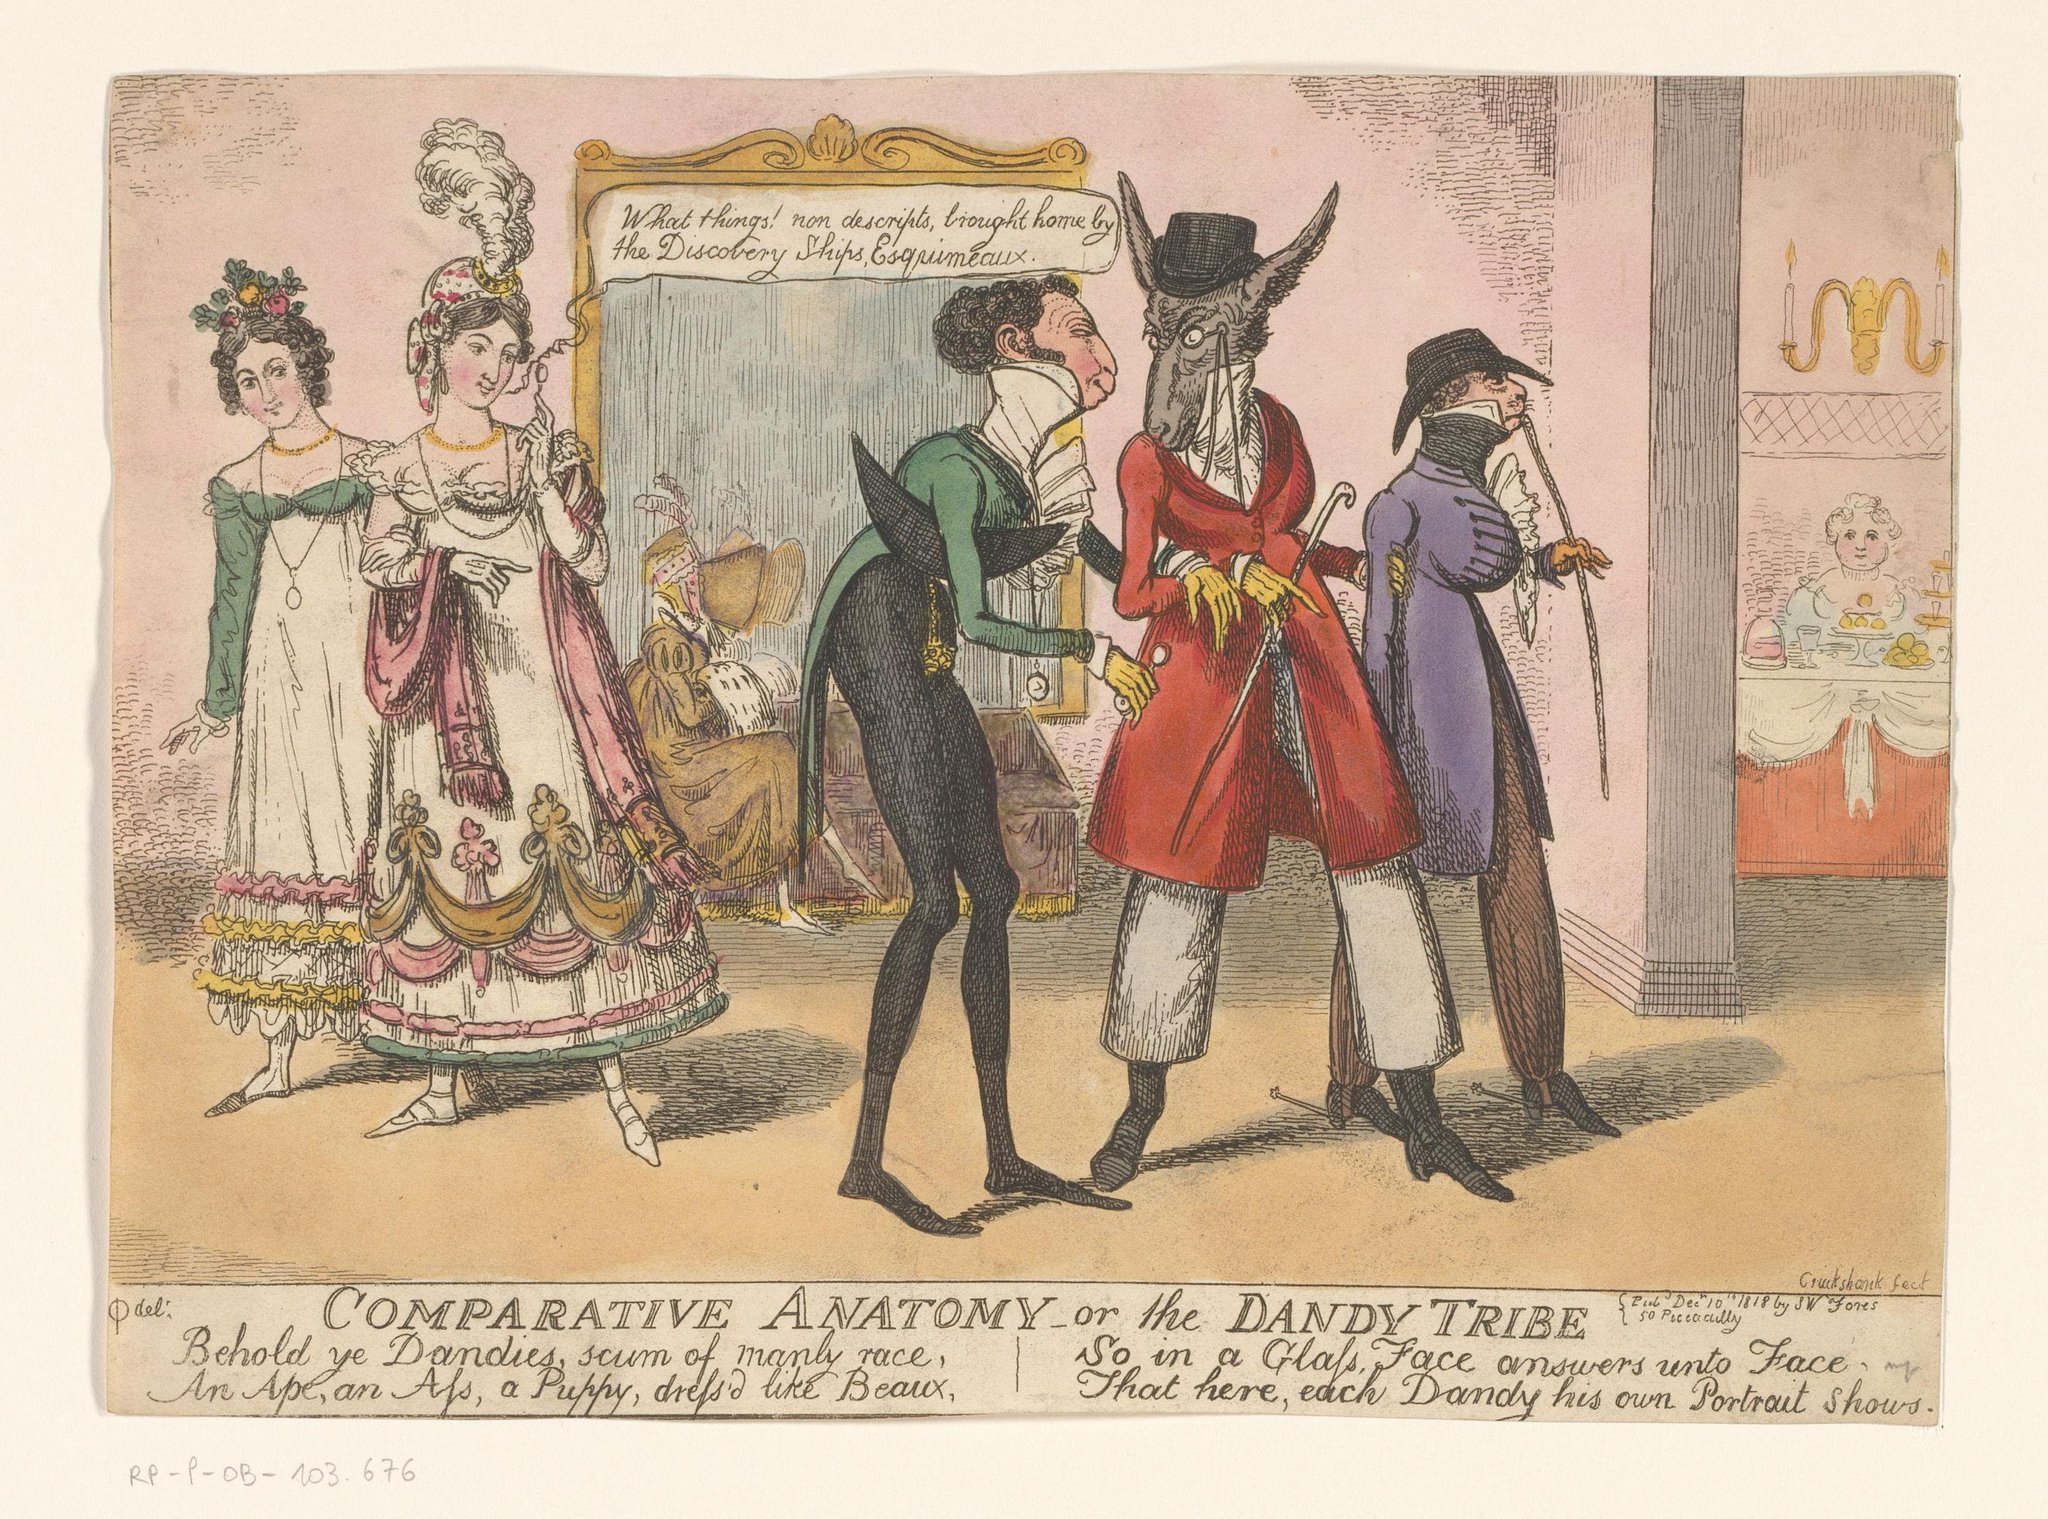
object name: cartoon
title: Comparative Anatomy - or the Dandy Tribe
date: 1818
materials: paper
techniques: etching, hand coloring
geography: london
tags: dandy, beau, political caricatures and satires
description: Spotprent met drie dandy's in de Assembly rooms te Bath. De middelste heeft een ezelshoofd. Twee vrouwen kijken hen na, rechts een taartjesverkoopster. In het onderschrift worden de drie types gekarakteriseerd als een aap, een ezel en een puppy.